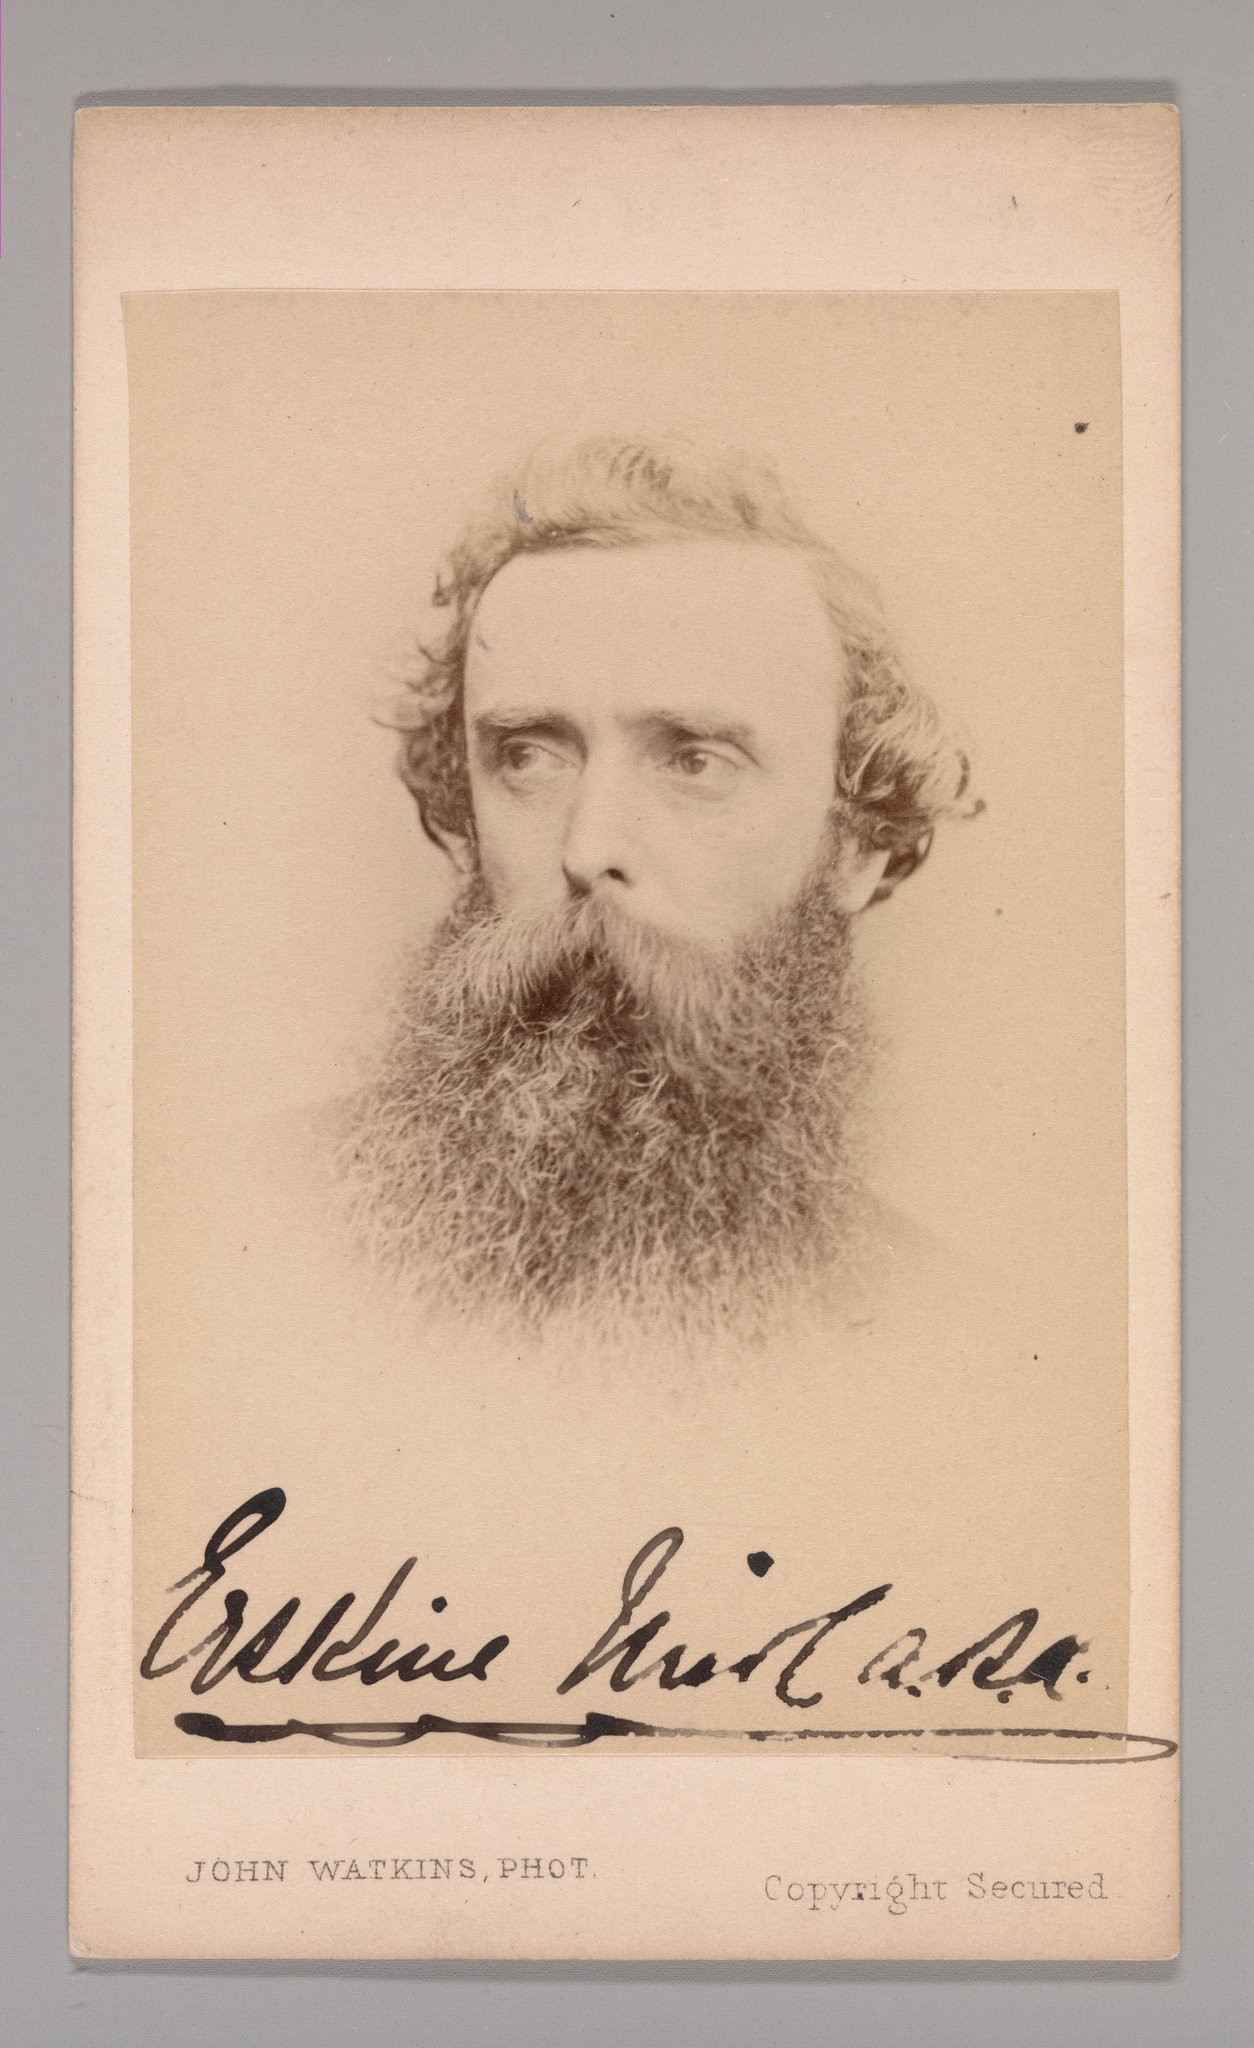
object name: carte de visite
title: [Erskine Nicol]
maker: john and charles watkins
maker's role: photography studio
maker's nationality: british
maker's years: 1840-1875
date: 1860-1869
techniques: albumen silver print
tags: men,portraits